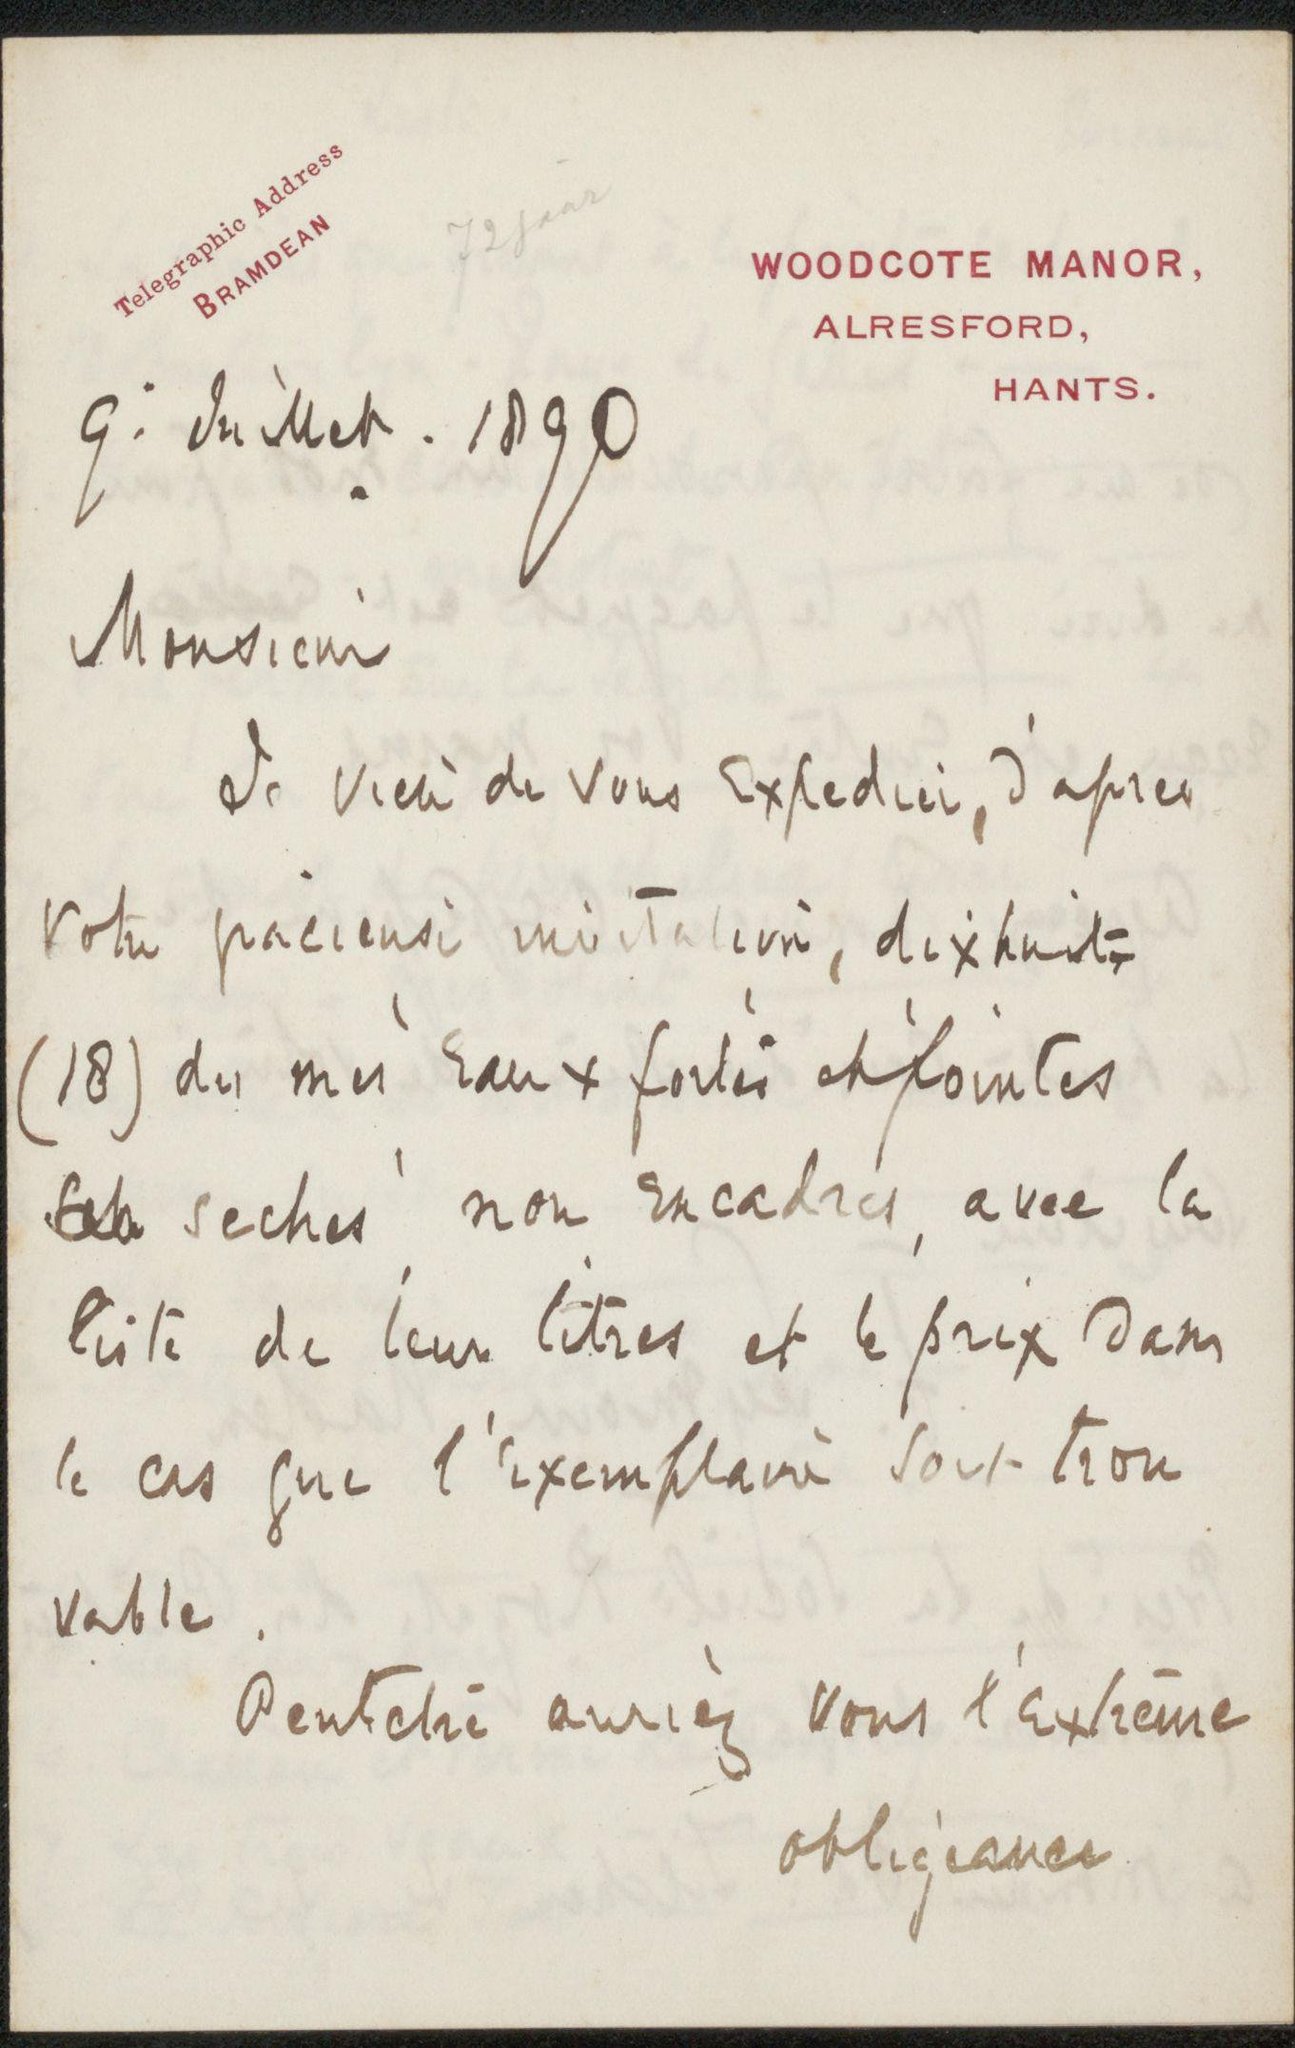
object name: letter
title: Brief aan Philip Zilcken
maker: francis seymour-haden (sir)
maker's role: print maker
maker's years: 1818-1910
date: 1890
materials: ink, paper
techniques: pen, printing, writing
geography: woodcote manor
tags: the hague, draughtsman, philip zilcken, the graphic arts, money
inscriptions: collector's mark: ‘RPK’